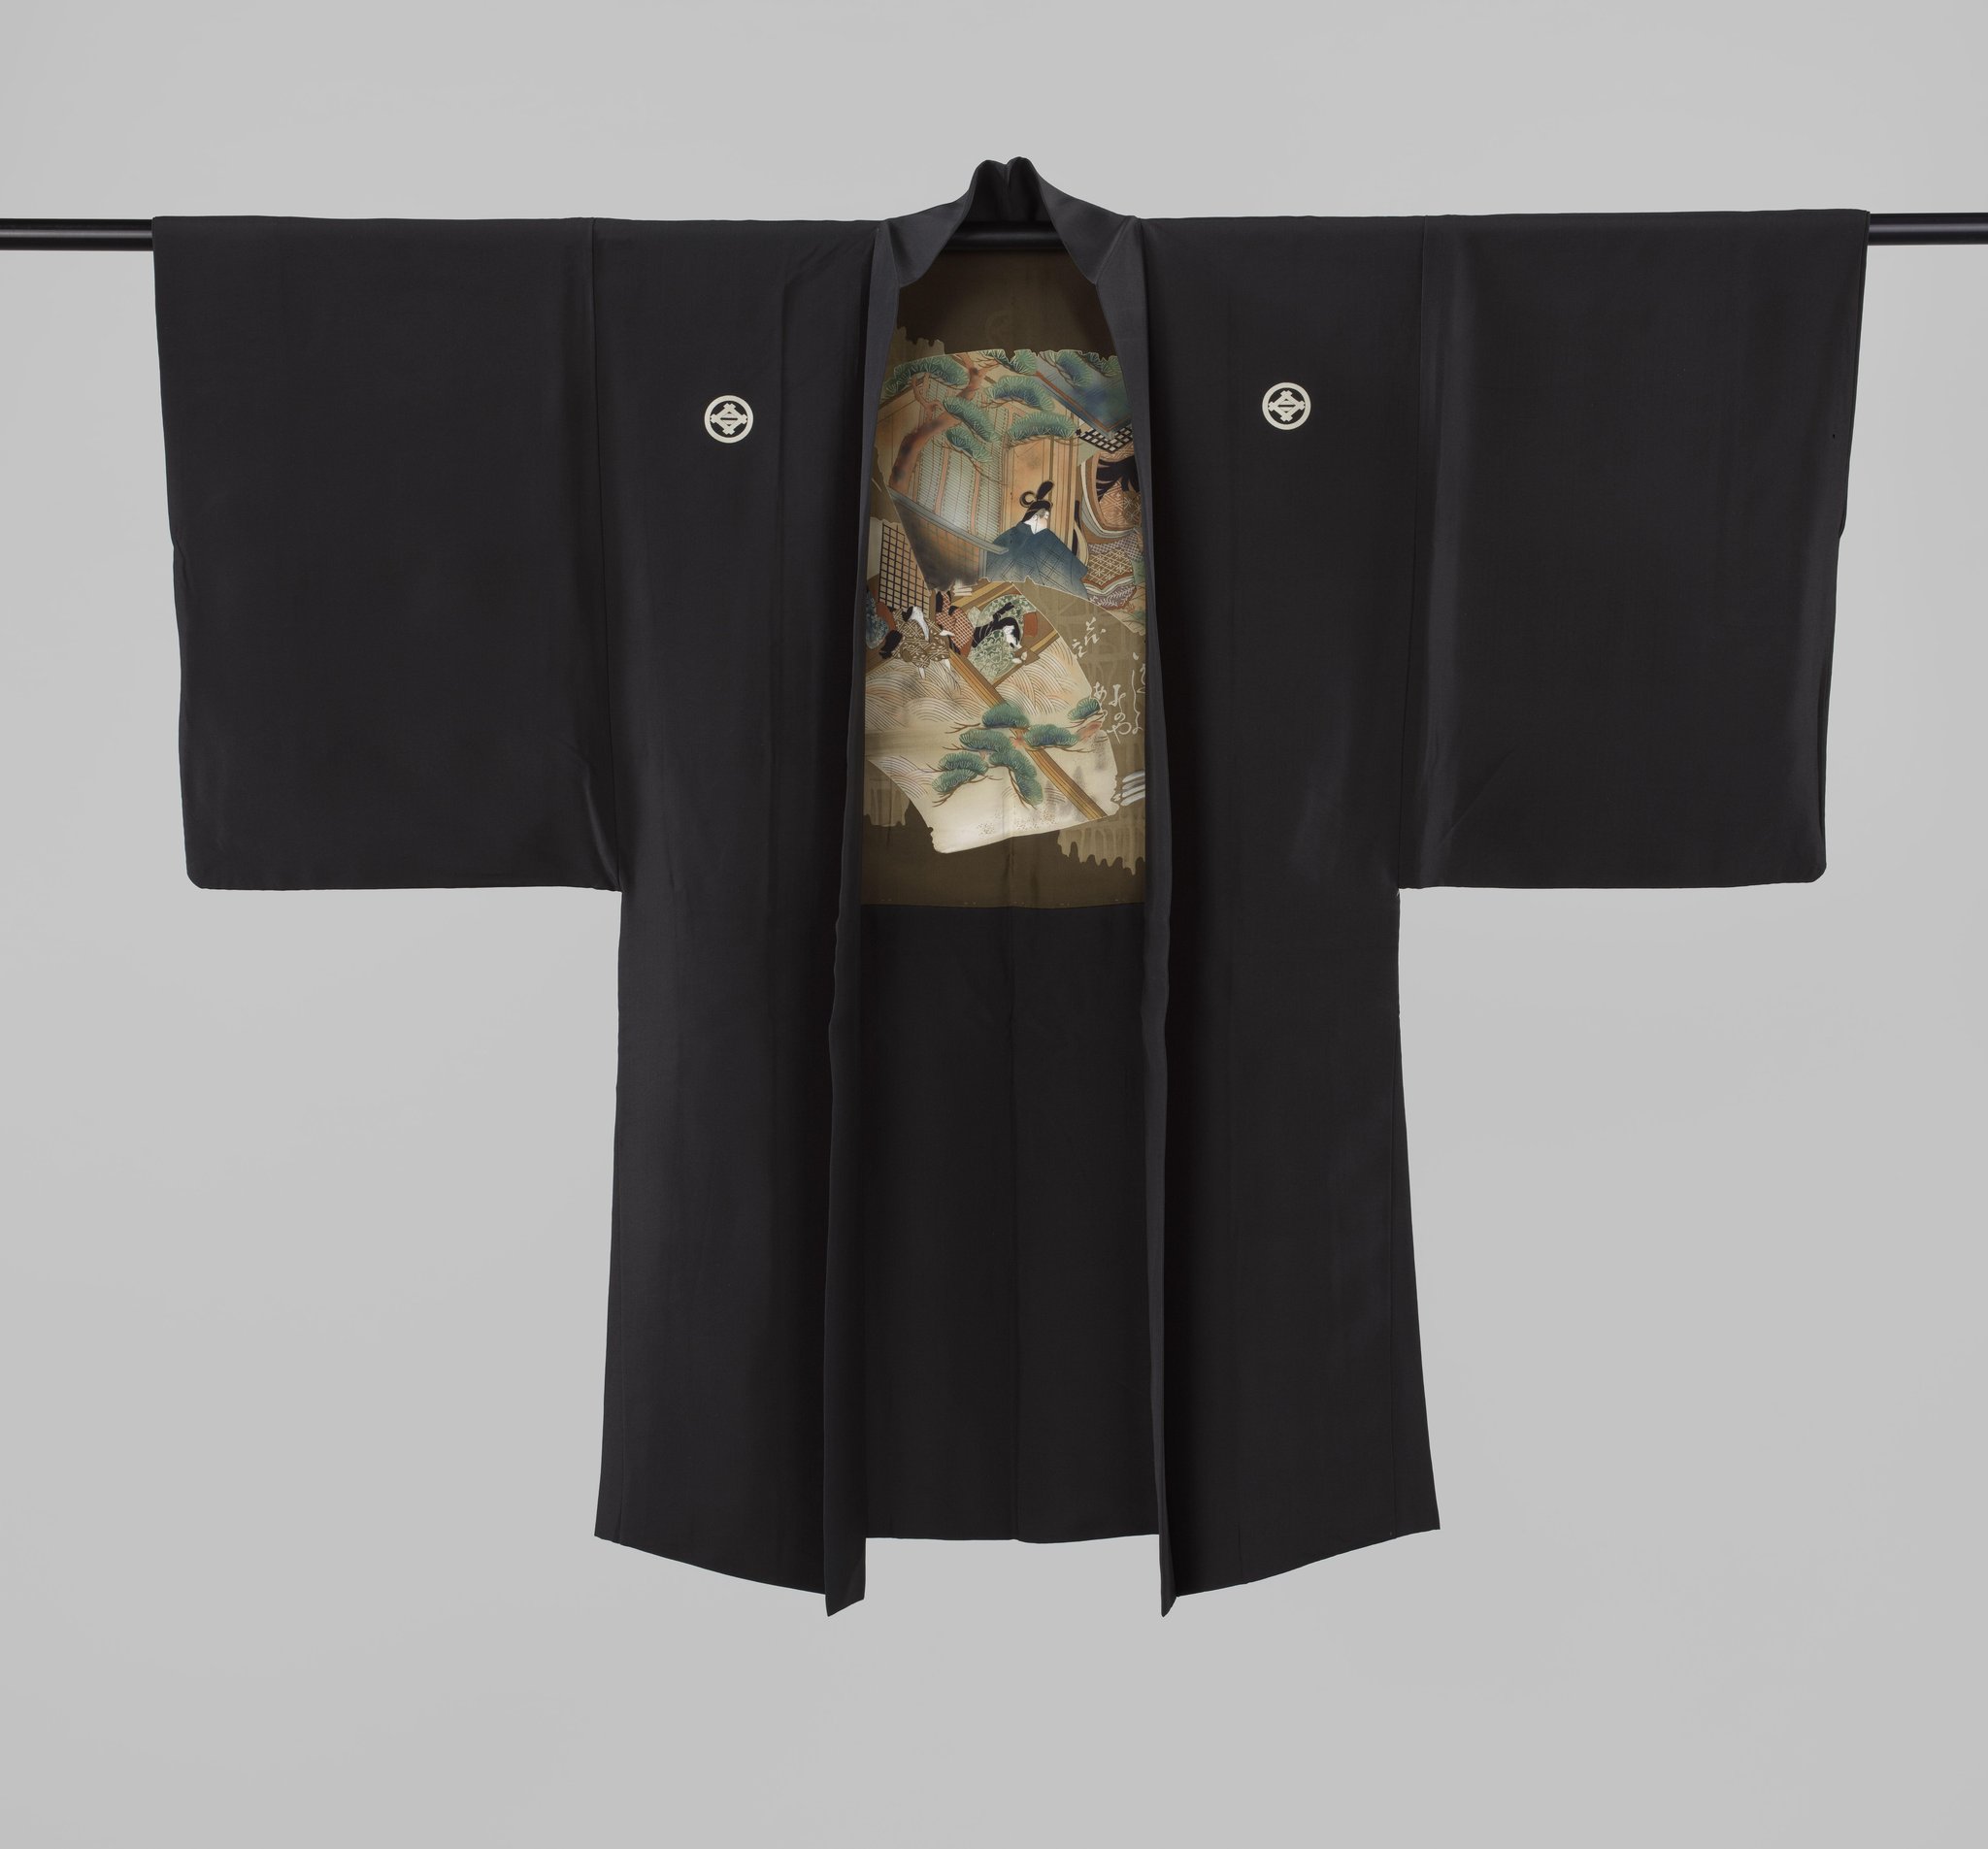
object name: kimono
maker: Anonymous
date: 1920-1940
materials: silk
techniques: weave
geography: japan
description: Kimonos: Mirrors of a Man’s Life. The kimonos on view here afford a glimpse into the lives of Japanese men from around the 1910s to the 1950s, from childhood to adulthood. This was a period of great change for Japan, marked by increasing industrialization and political conflicts culminating in the Second World War. Life modernized, technology advanced, and people took up new hobbies. Traditionally, men’s outer clothing tended to be reserved and a solid colour. Clothes could nevertheless also be a medium for highly unusual depictions which, however, were not visible to everyone. While motifs adorned the exterior of children’s garments, they were hidden from view in those worn by adult men. The decoration was found on the inside: on a long under garment, or the lining of a jacket (haori). This concealed imagery divulges the lives of the owners at the beginning of the 20th century. Childhood. A kimono marked events and stages in a man’s life. The kimonos on the top row (except the two everyday ones at either end) were worn by boys during the religious ceremony of miyamairi, namely an infant’s first visit to a Shinto shrine. This event followed a prescribed ritual and was an important and formative moment in the life of a Japanese man. Clothing for boys enveloped them in images that were to become part of their identity. The depictions included motifs that were considered gender and age appropriate: toys, manly hobbies, stories of heroic battles, technology, and so forth. Broader themes such as military conflicts and nationalism also filtered into children’s daily lives at an early stage. The textile designs of some kimonos combined traditional playthings with toy guns and tanks. Adulthood. What does a kimono tell about its owner and his life? Some men chose subjects from classical culture, such as No or Kabuki theatre, while others preferred themes from contemporary life, such as gramophone records or the new popular sport of baseball. Thus, these garments were a canvas for personal choices, but also for political propaganda and nationalistic messages. Some representations are eccentric or even erotic. Others are more general and linked to political events. All aspects of a man’s inner life are touched on. Portraits of beautiful women and playful dogs contrast with images of war, celebrating victories in China. As these representations were under the outer garments, they remained hidden from the outside world and were thus seen only by the kimono’s owner and his intimates.